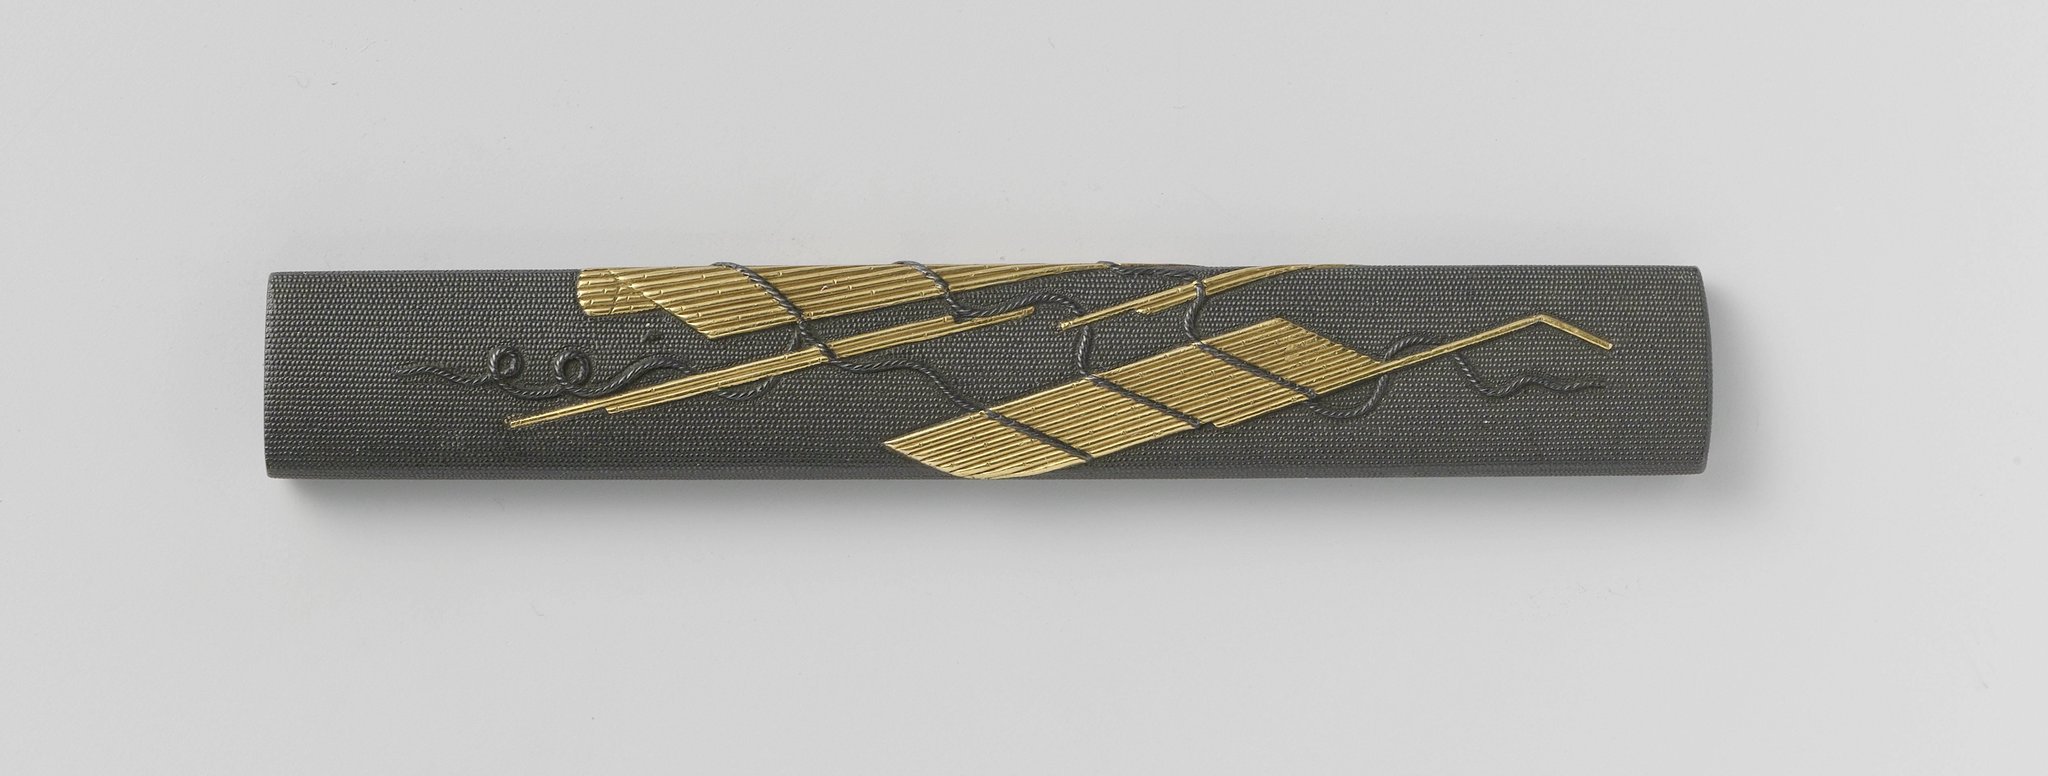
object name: zwaardmesheft, kozuka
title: Sword knife hilt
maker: goto denjo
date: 1500-1900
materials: gold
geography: japan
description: Kozuka with broken reed blind design. 18th century; signed: Gotô Denjô (? - 1712); shakudô, gold.